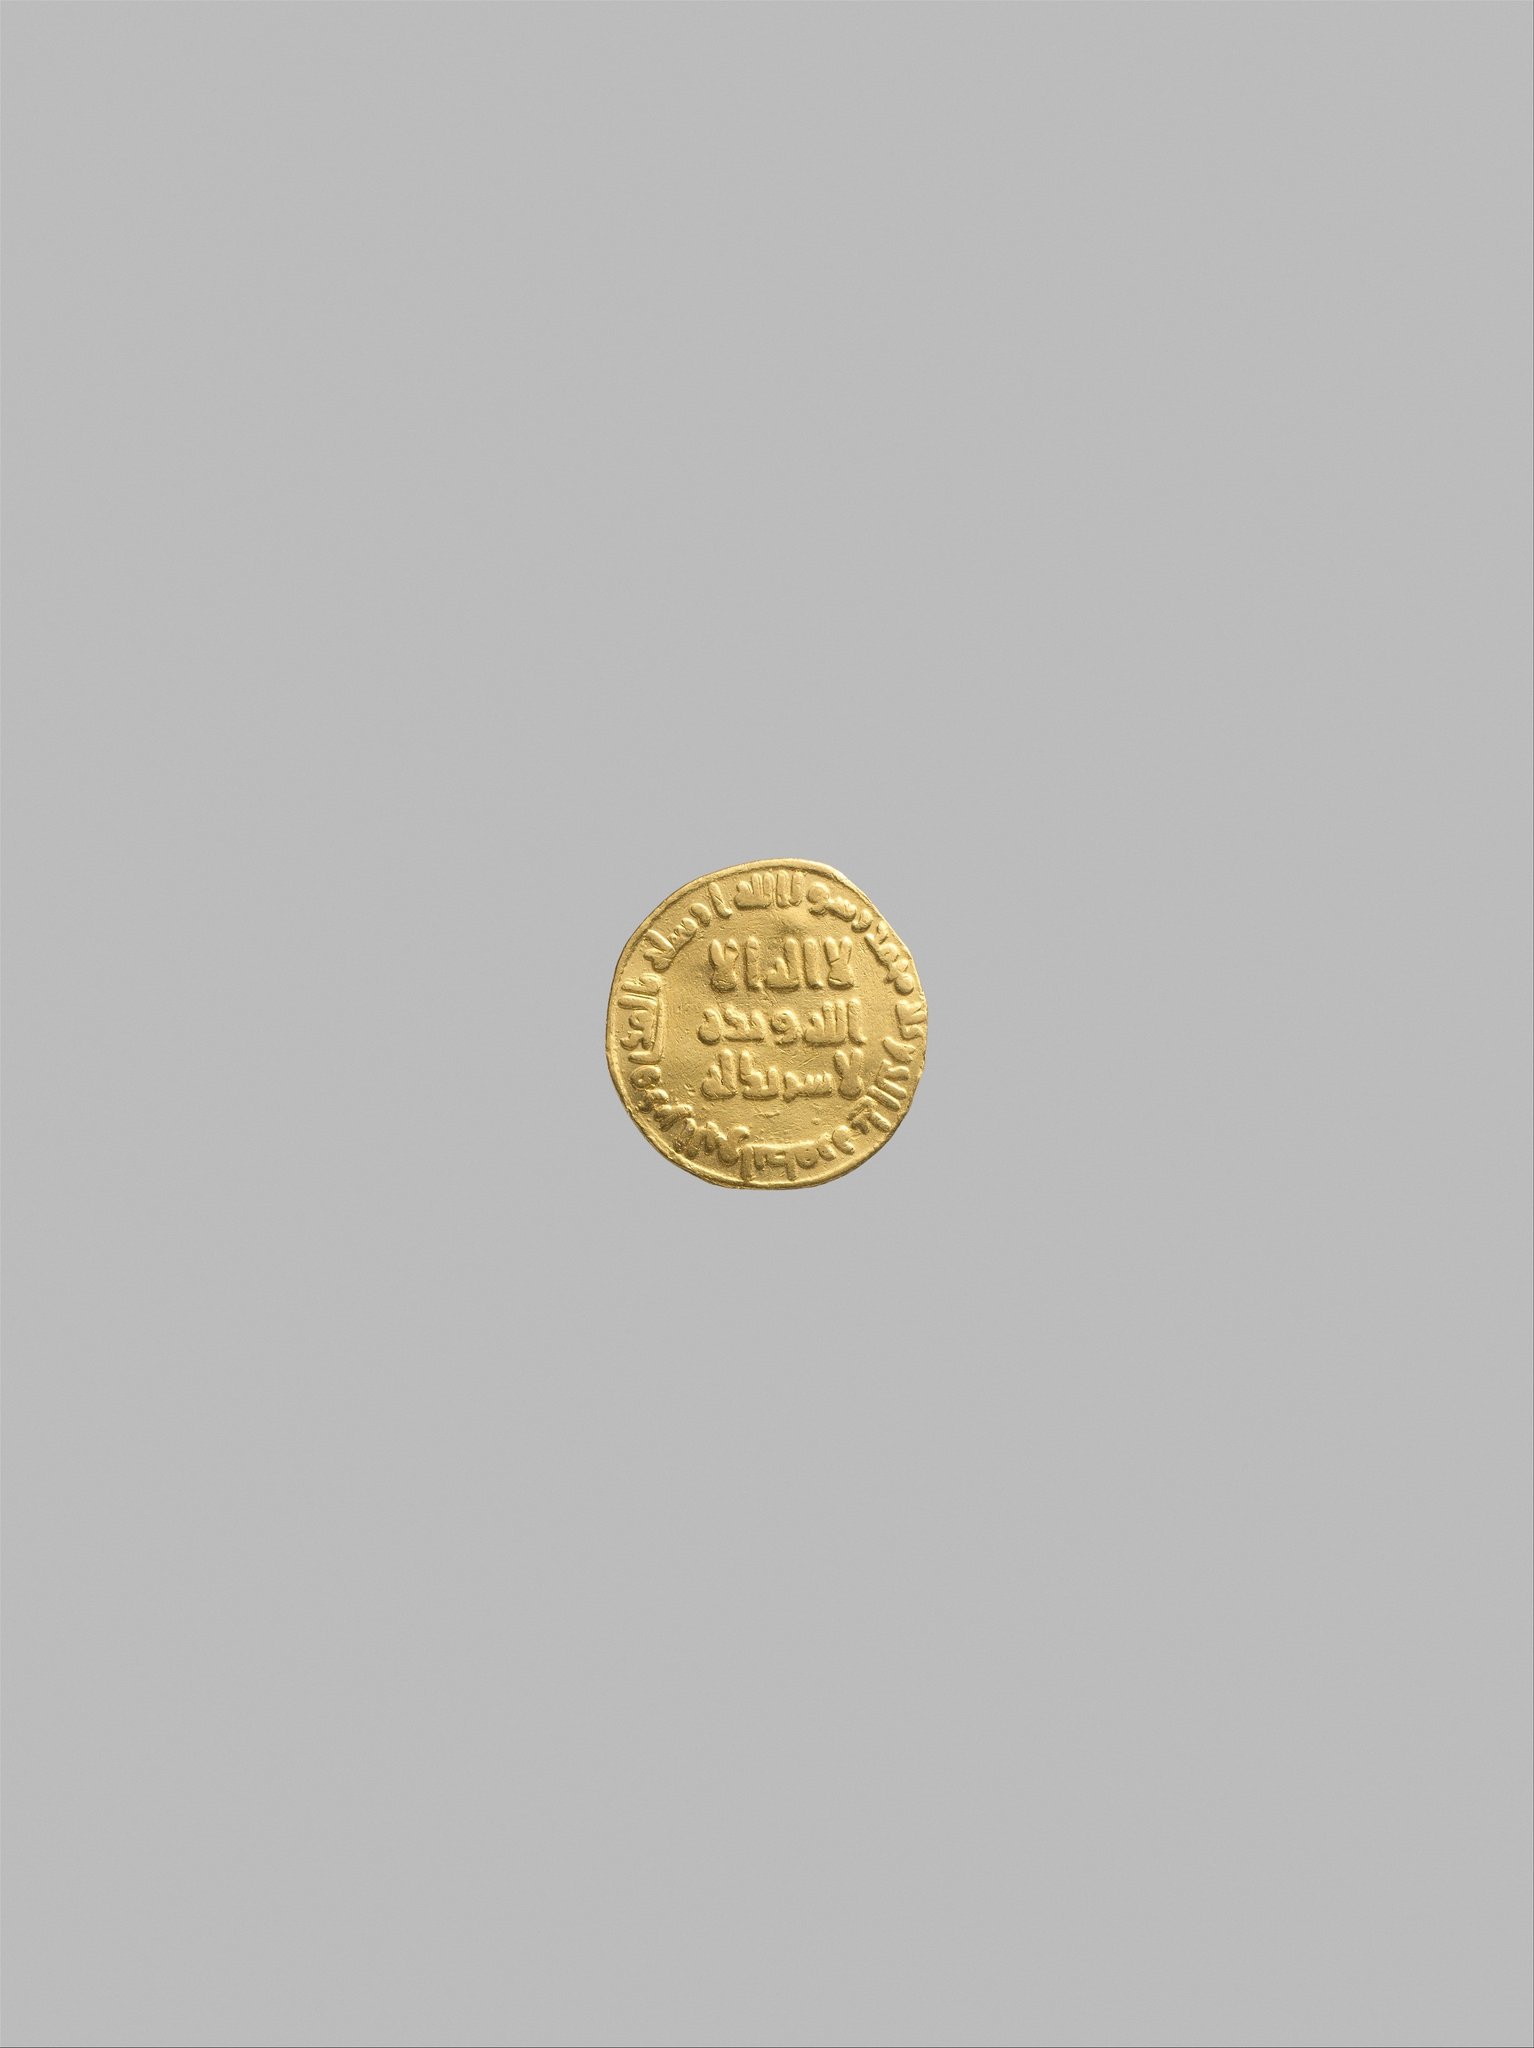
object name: coin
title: Dinar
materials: gold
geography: syria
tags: arabic